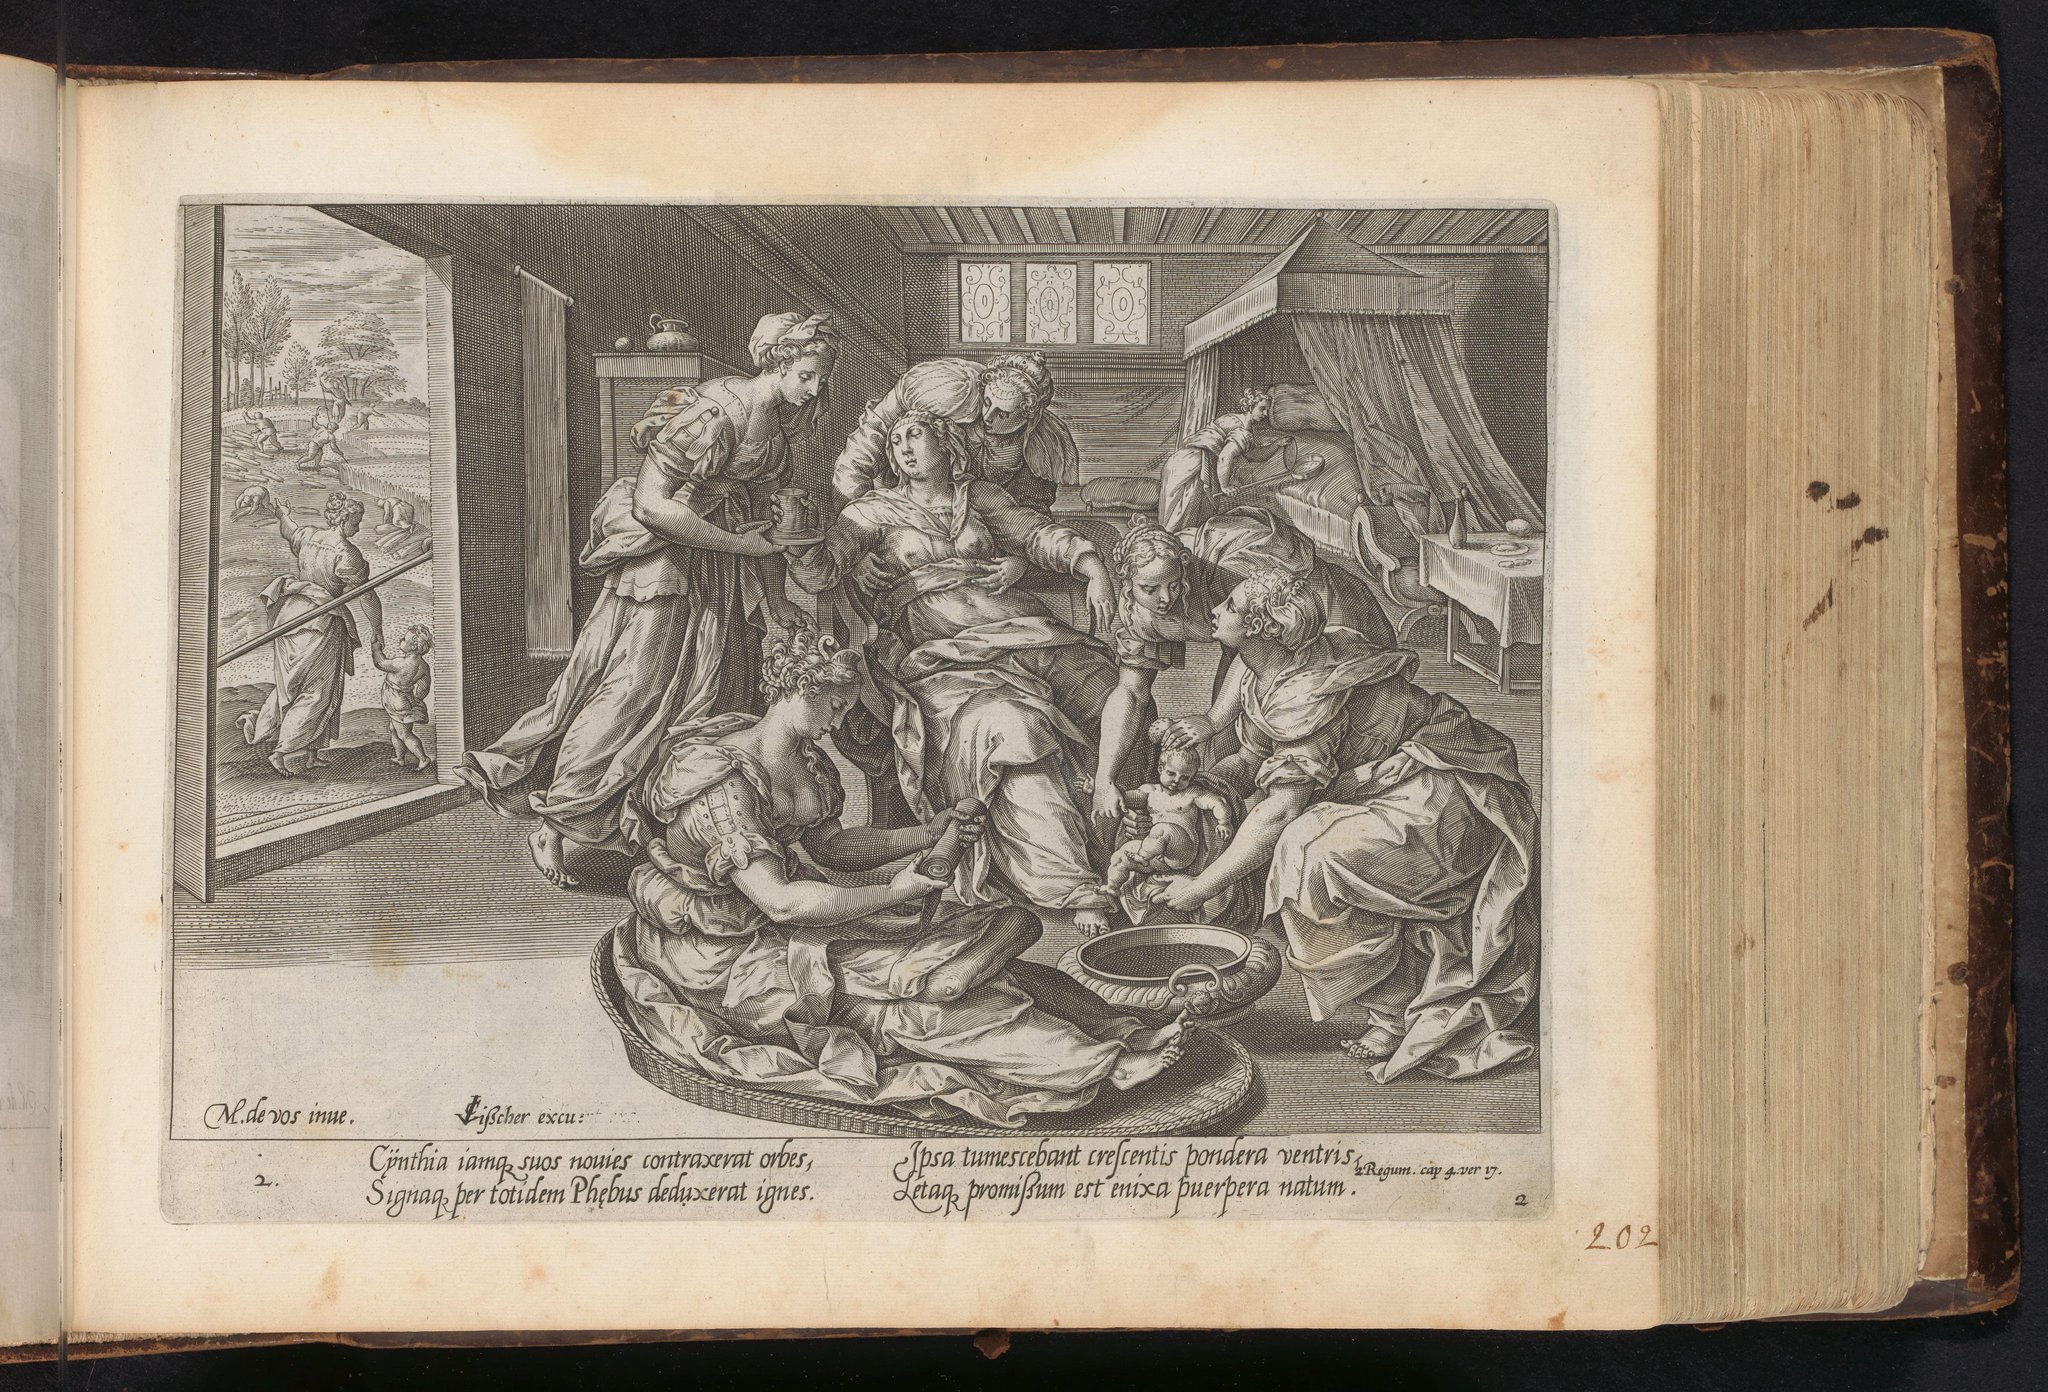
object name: album leaf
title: Geboorte van de zoon van de vrouw uit Sunem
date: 1579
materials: paper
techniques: engraving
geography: alkmaar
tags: lying-in room, birth of the son of the shunammite woman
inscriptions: number: ‘202’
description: Op de voorgrond baart de vrouw uit Sunem een gezonde zoon. Ze wordt ondersteund door vroedvrouwen en het kind wordt gewassen. Op de achtergrond links gaat ze met haar kind kijken naar de maaiers op het veld. Onder de voorstelling een verwijzing in het Latijn naar de Bijbeltekst in 2 Kon. 4:17. Deze prent maakt deel uit van een album.